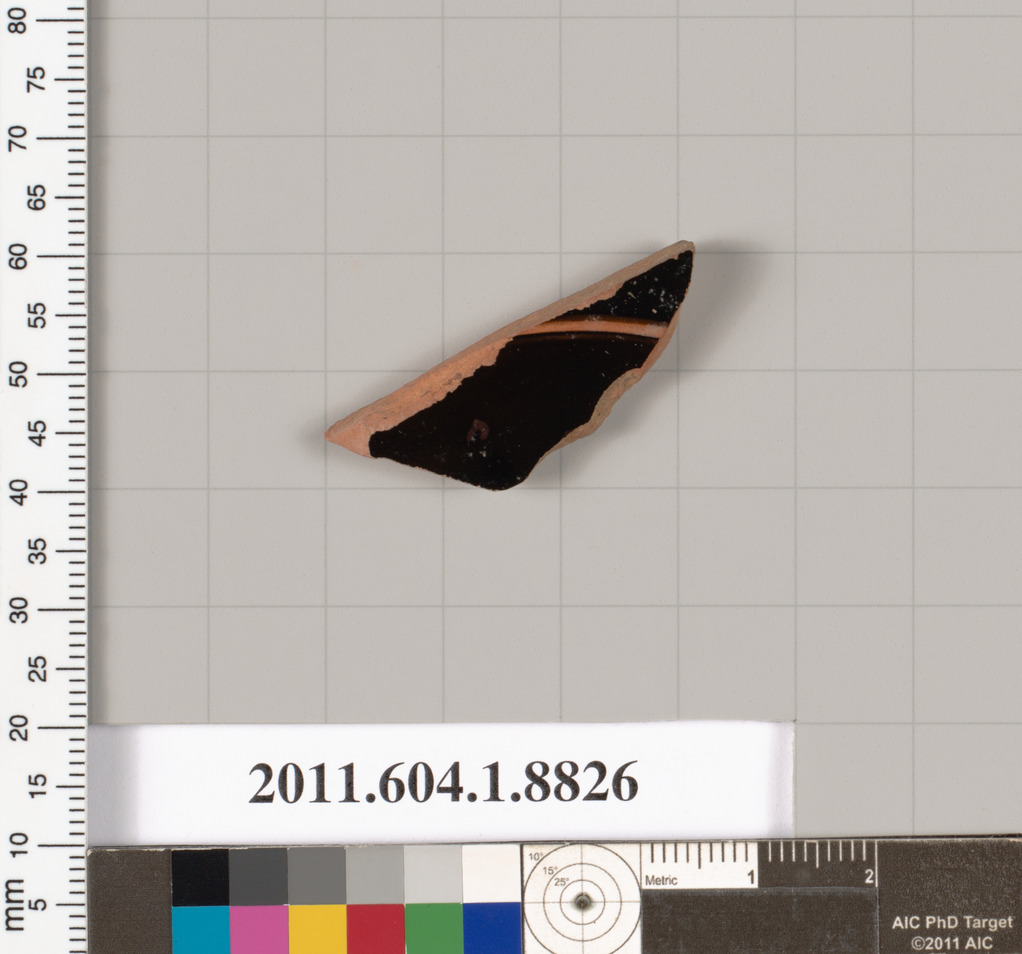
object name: kylix fragment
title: Terracotta fragment of a kylix (drinking cup)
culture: greek, attic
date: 490-480 BCE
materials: terracotta